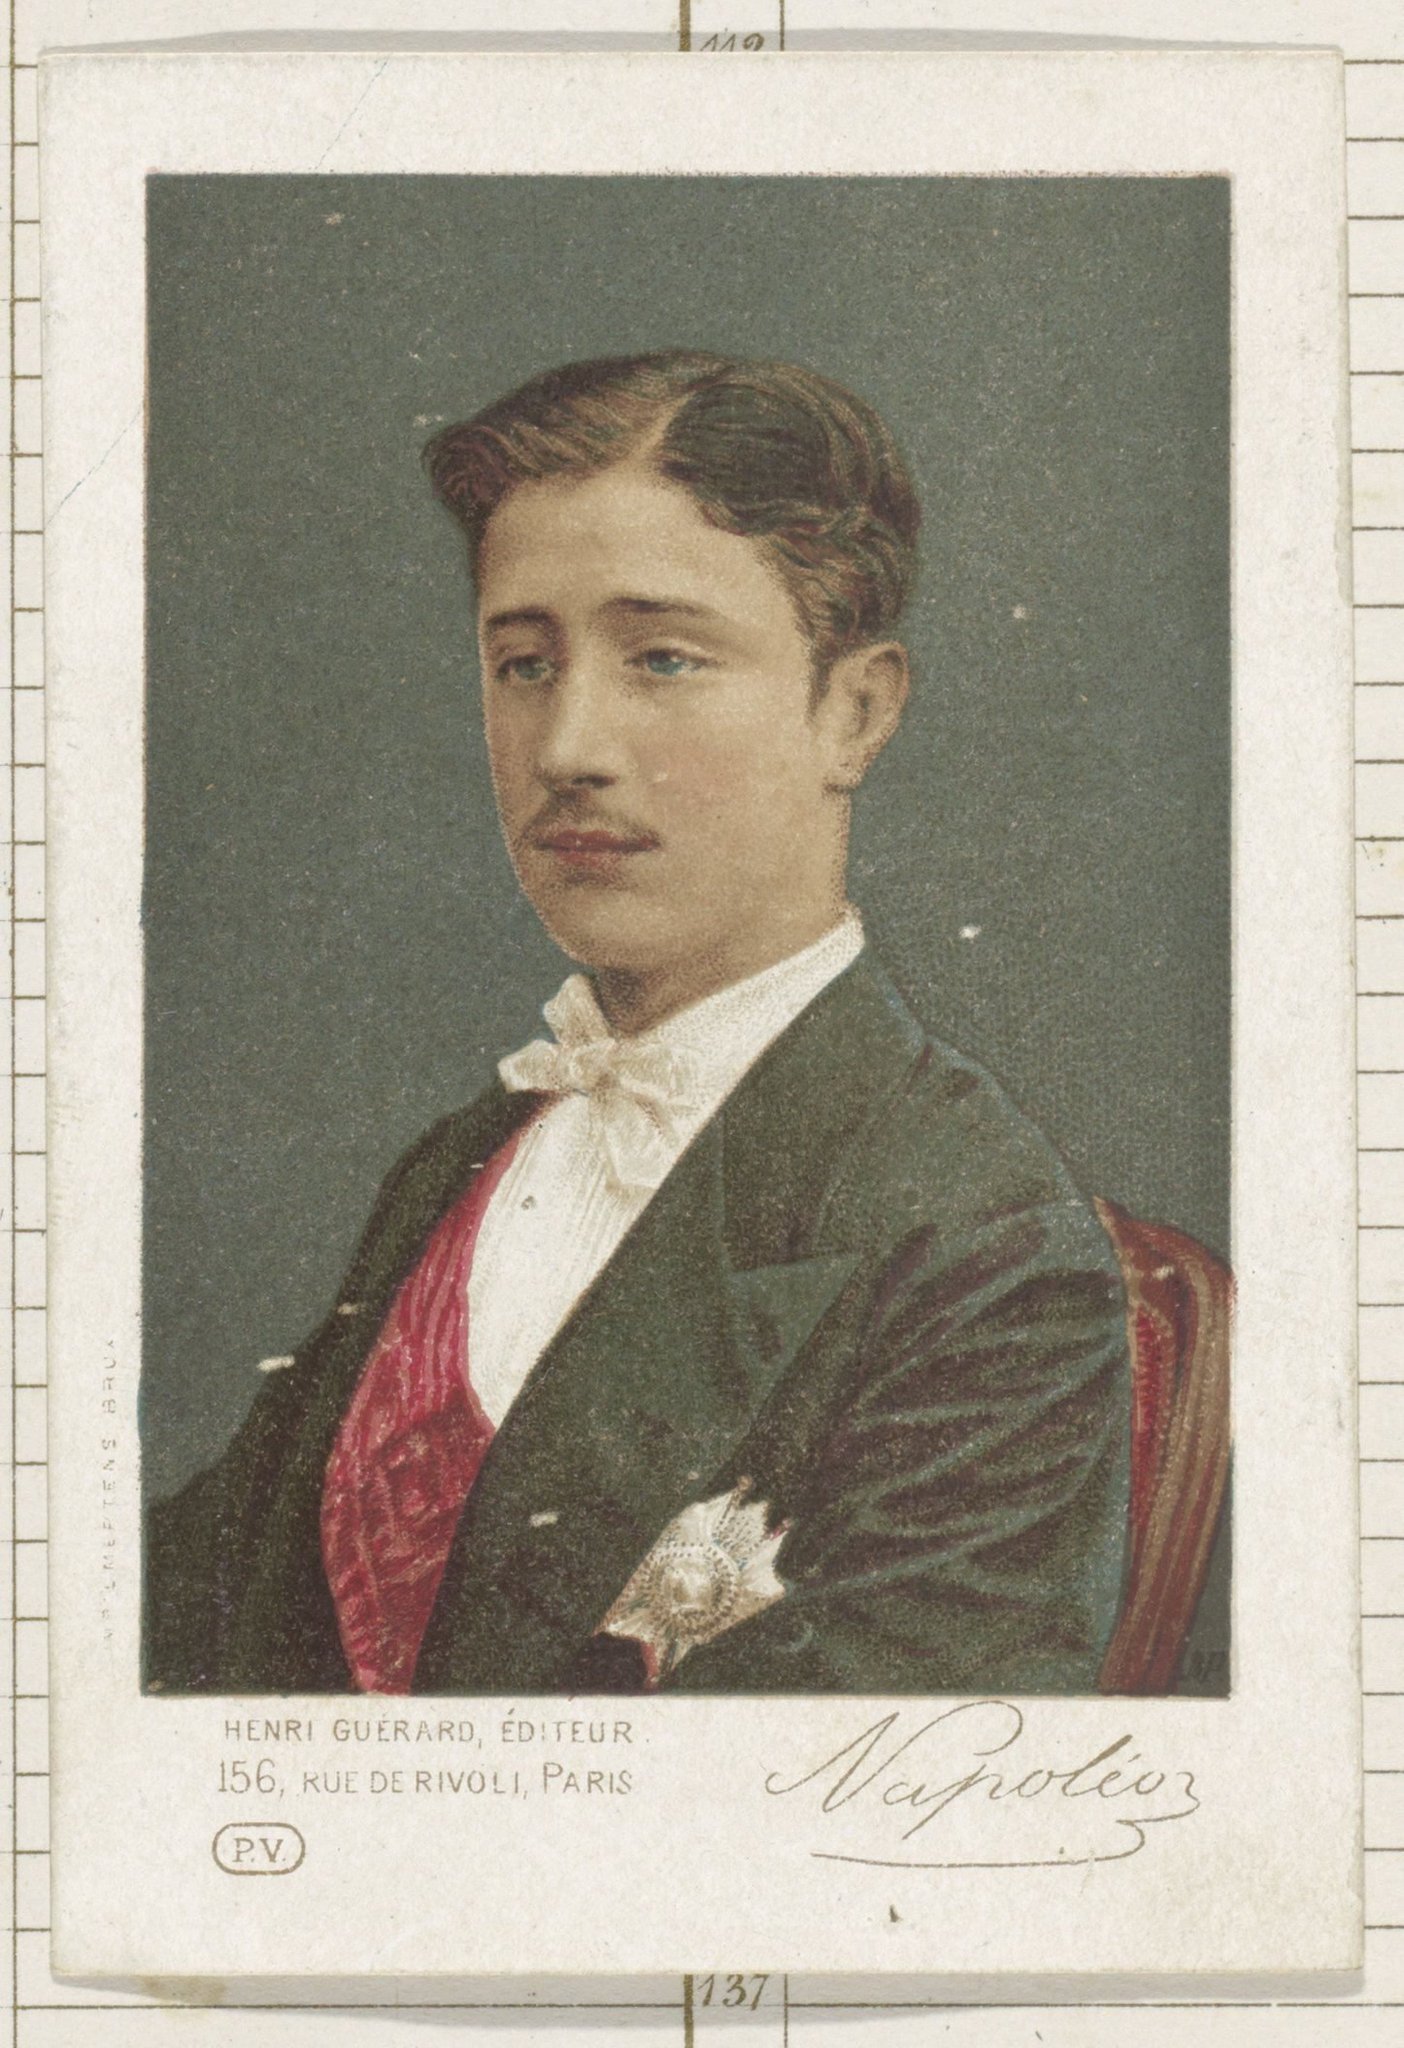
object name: print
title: Portret van Napoleon Eugène Bonaparte, kroonprins van Frankrijk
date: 1865-1880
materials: cardboard, paper, photographic support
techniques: lithograph, hand coloring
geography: brussels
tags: paris, moustache, neck-gear ~ clothing, clothing for the upper part of the body, decorations, honours (as symbols of the state, etc.)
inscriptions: address: ‘156 Rue de Rivoli (editeur)’, name: ‘[...] Imp. L. Mertens Brux.’, initials: ‘P.V.’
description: Onderdeel van Fotoalbum met 123 cartes-de-visite van leden van Europese vorstenhuizen, politici en bekende personen.